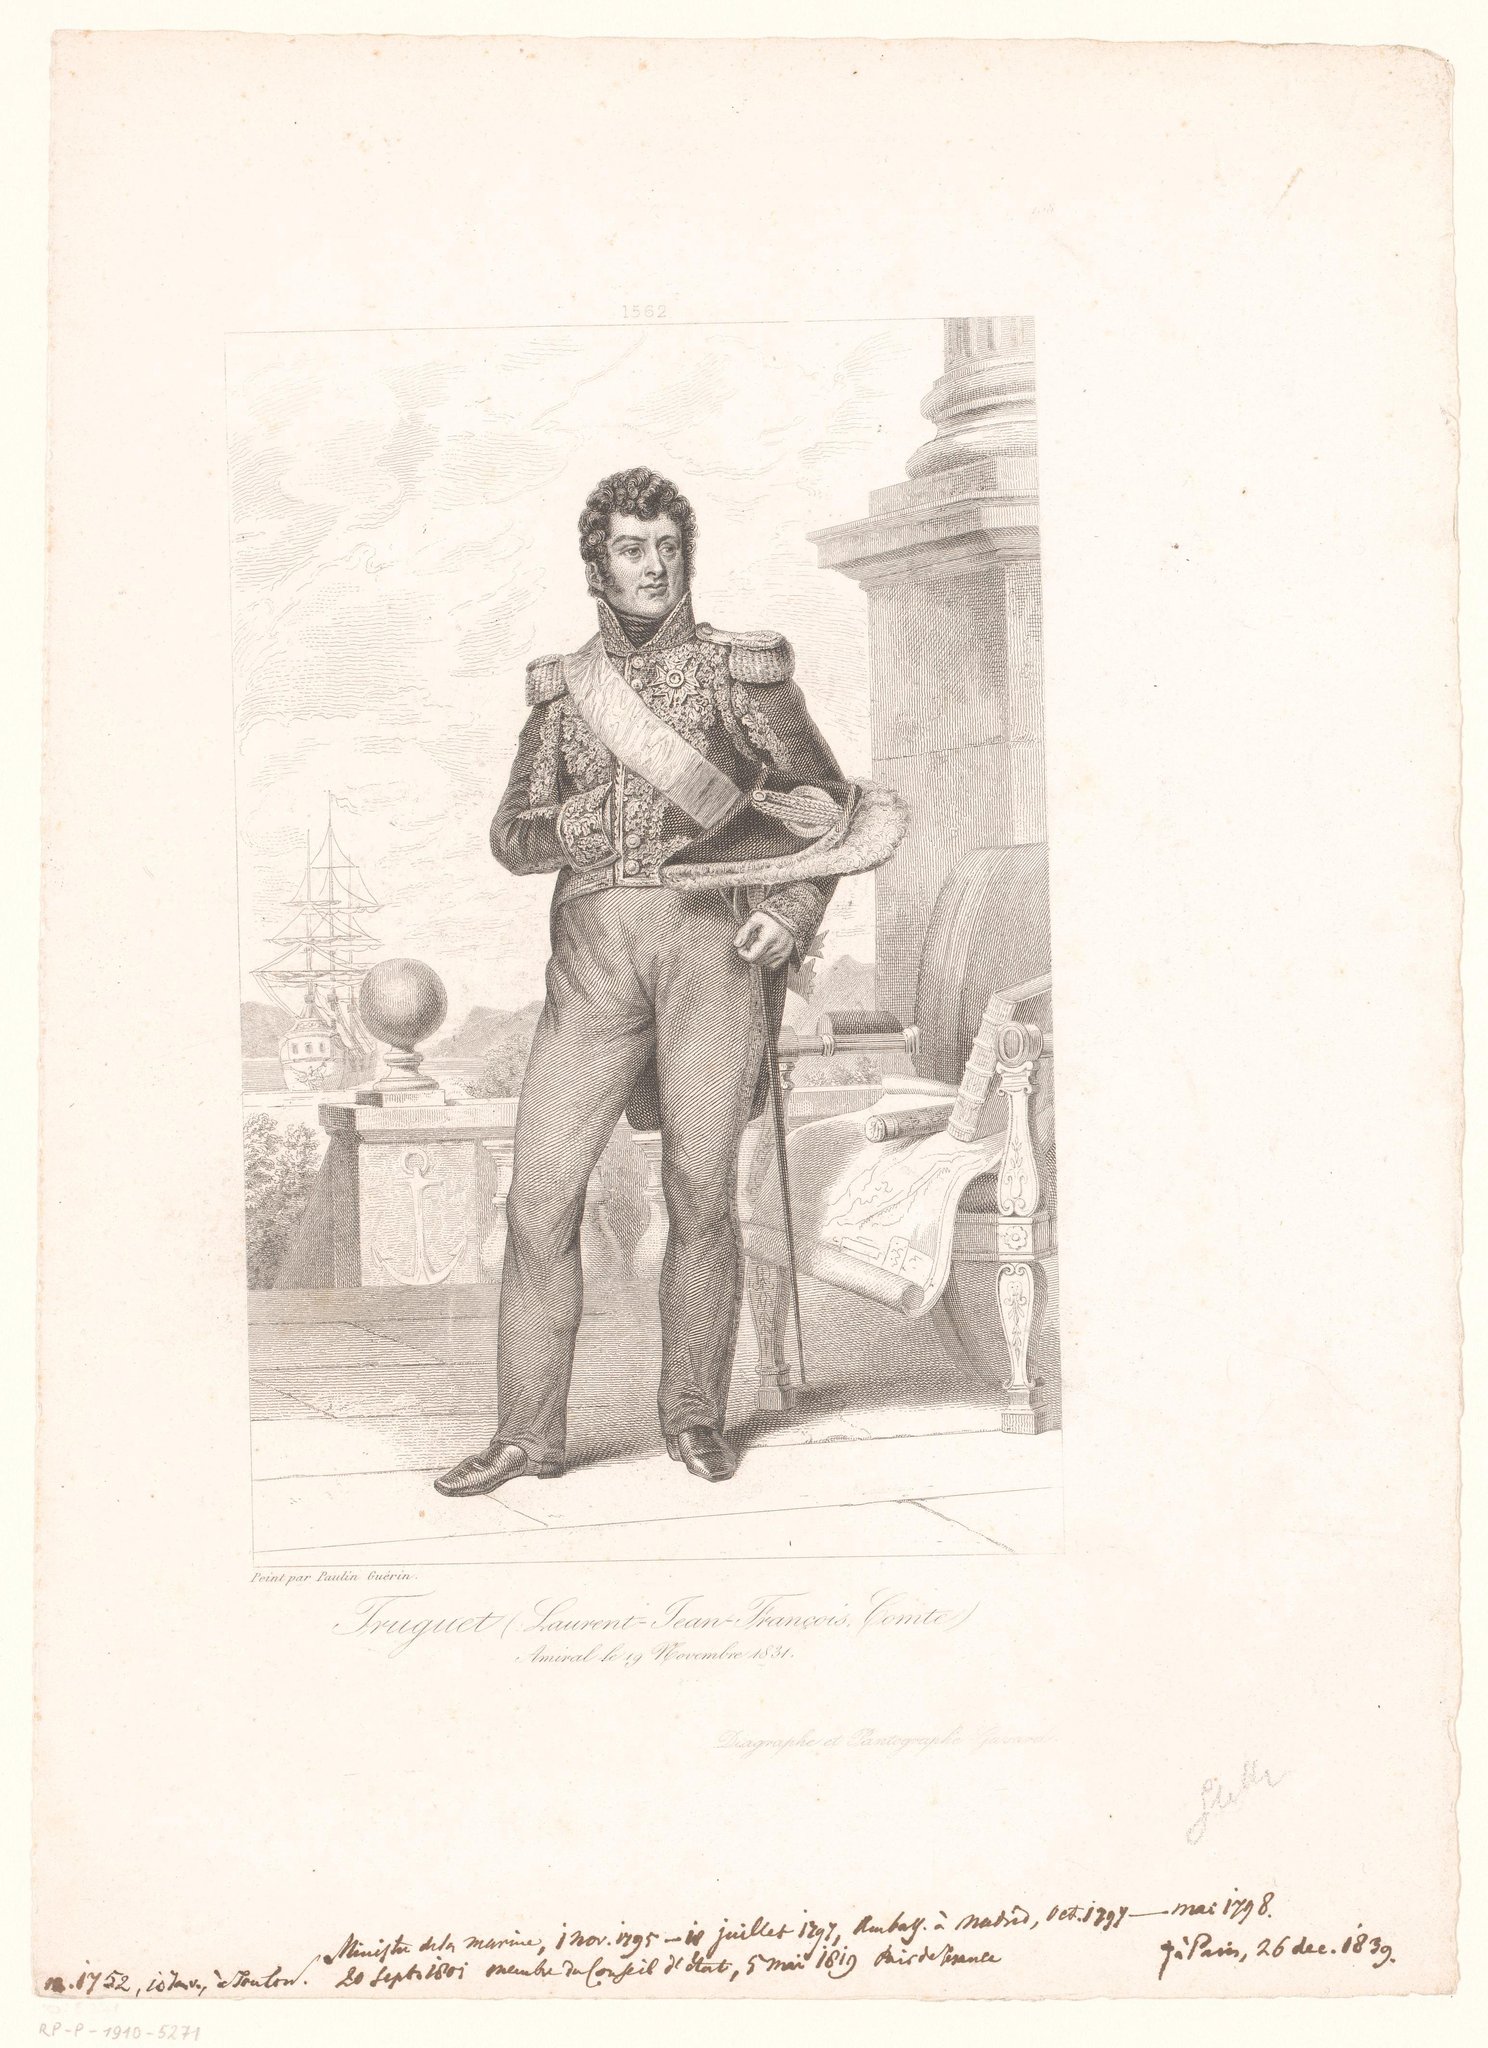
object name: book illustration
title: Truguet (Laurent-Jean-François Comte)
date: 1838-1841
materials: paper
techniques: engraving, etching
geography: france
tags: toulon, marine charts, historical persons, ships (in general), telescope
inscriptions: collector's mark: Lugt 2228, inscription: ‘Ministre de la marine, 1 nov. 1795 - 18 juillet 1797 (...)’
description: Prent uit: Galeries historiques de Versailles. Parijs: Charles Gavard, 1838-1841.